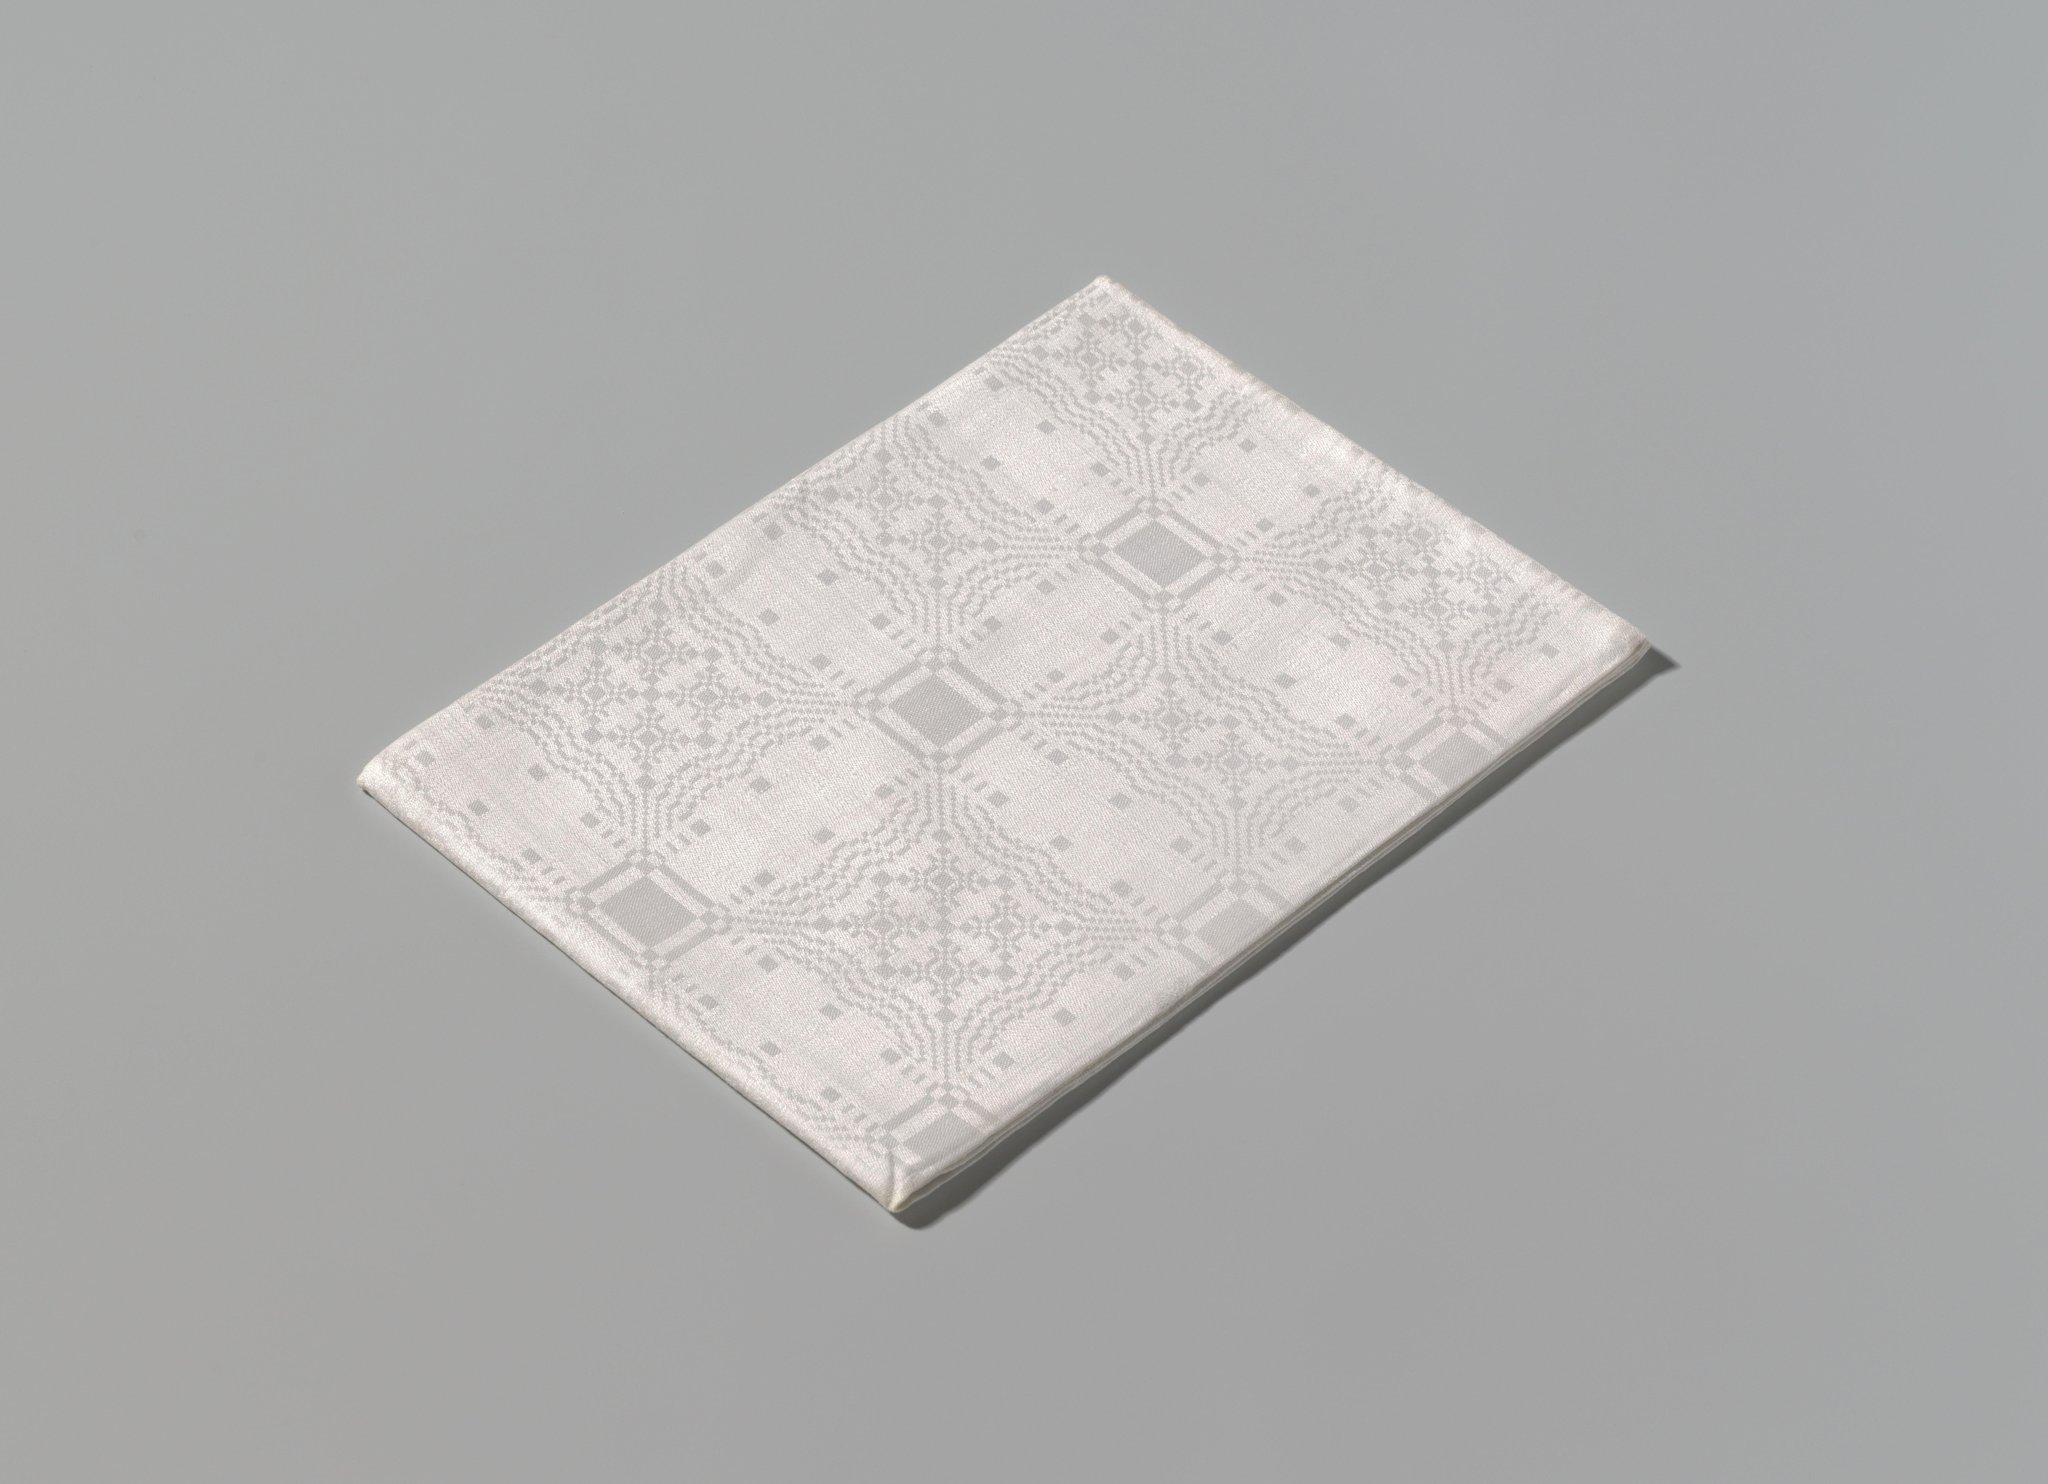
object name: napkin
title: Servet van linnen met pellenpatroon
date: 1725-1775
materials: linen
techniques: peeled fabric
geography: northern netherlands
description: wit linnen servet met pellen patroon, merk IB HW